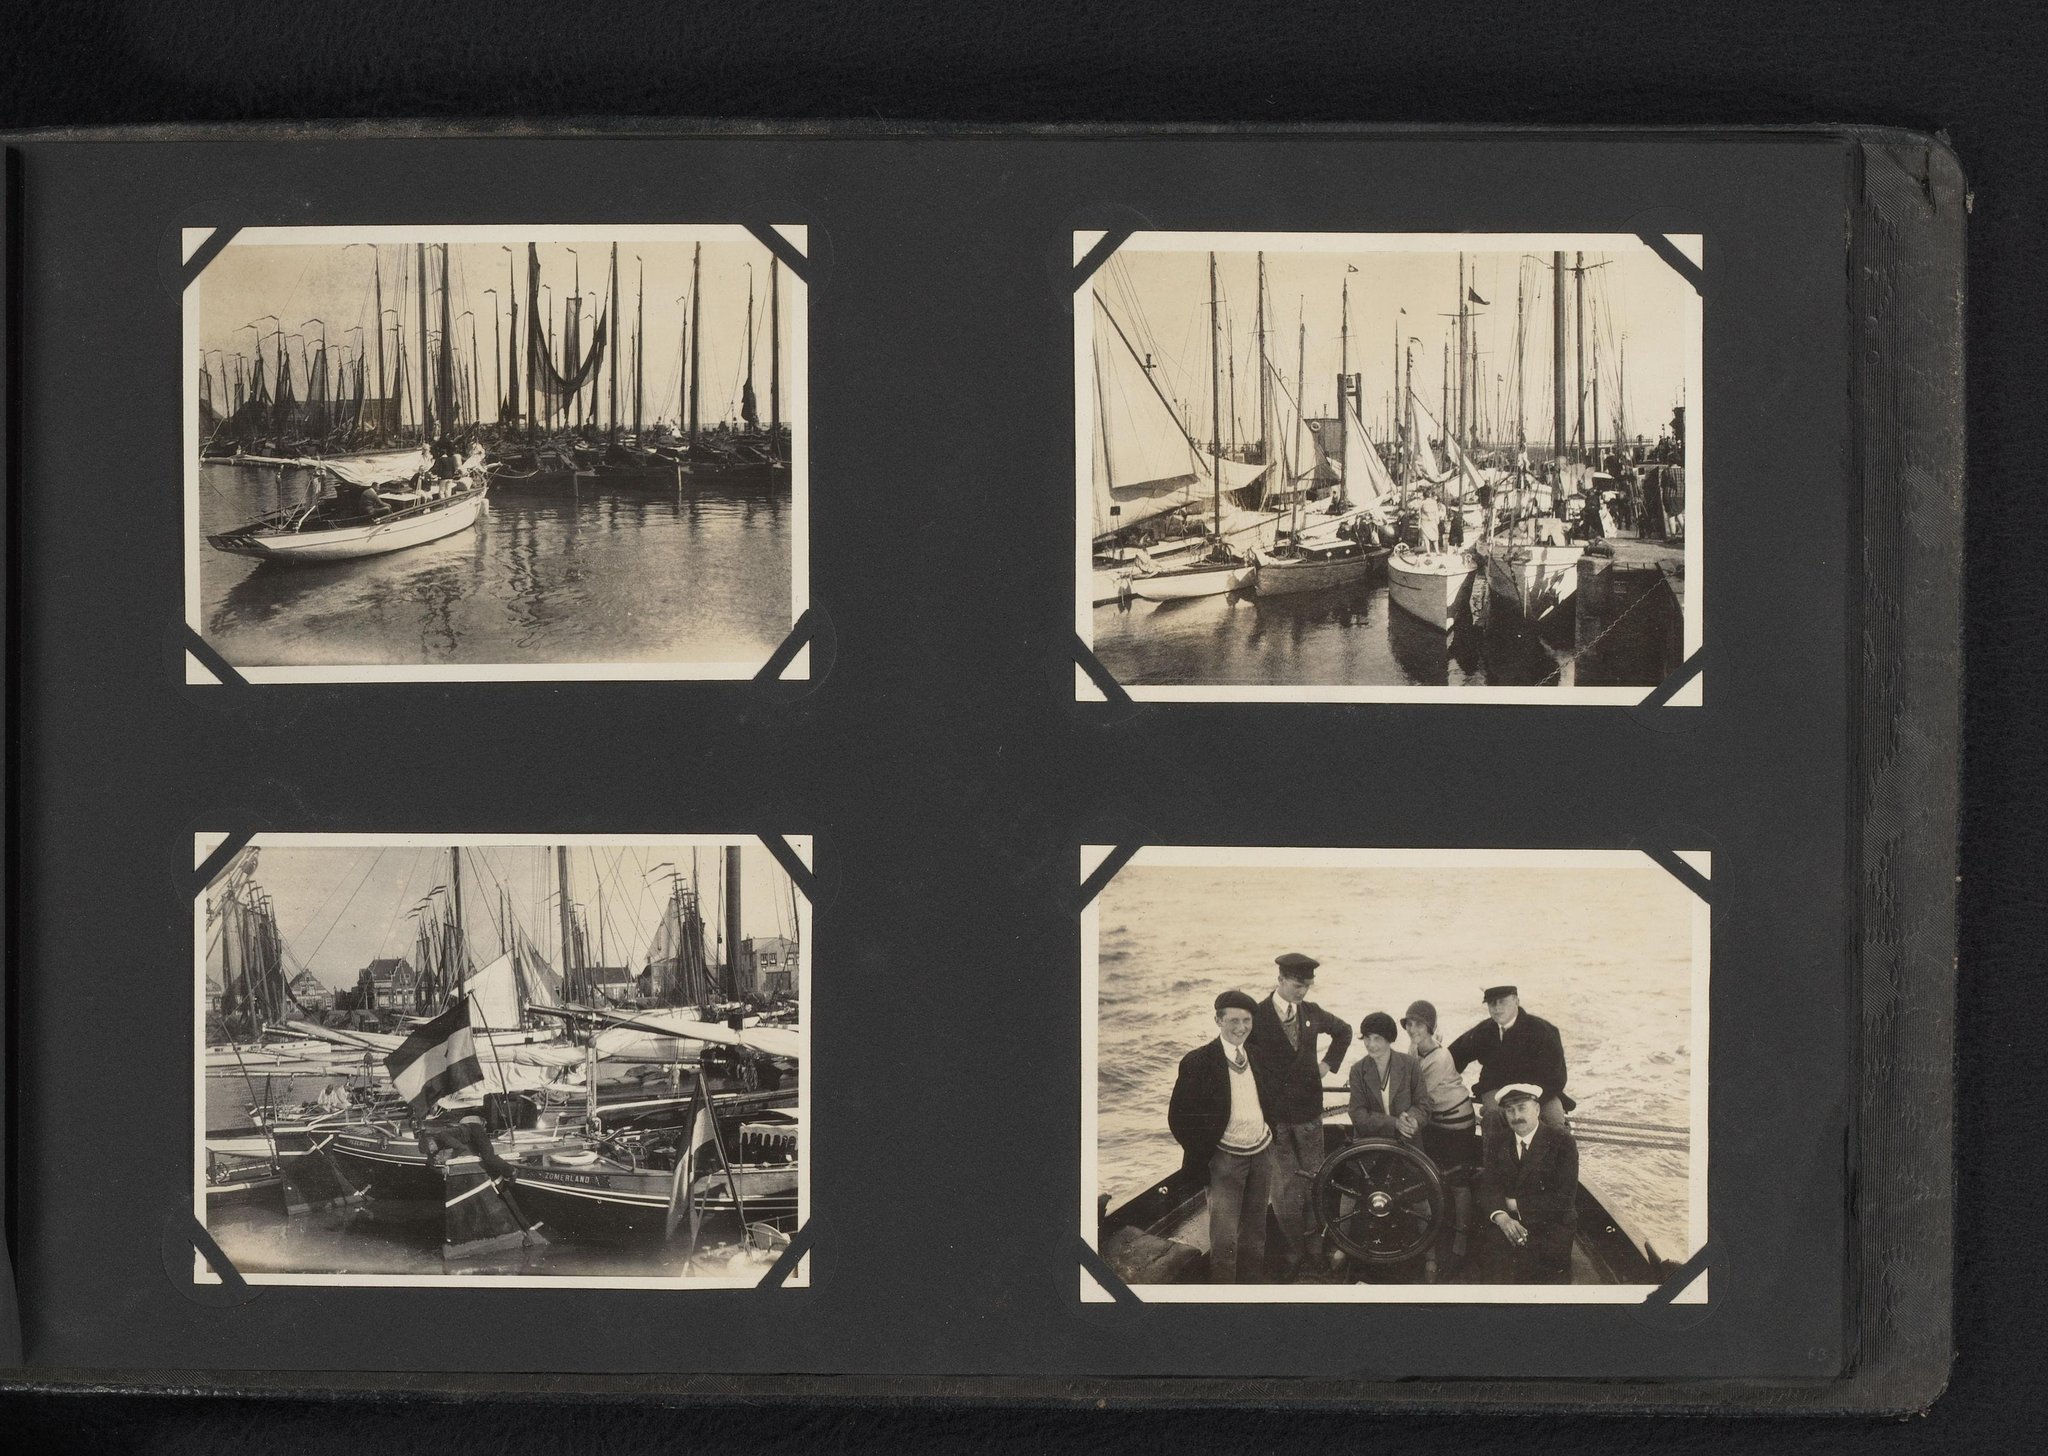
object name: album leaf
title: Vier foto's van een haven en een gezelschap op een boot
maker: hendrik herman van den berg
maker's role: amateurfotograaf, jurist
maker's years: 1875-1944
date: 1928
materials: paper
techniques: gelatin silver print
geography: netherlands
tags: sailing-ship, sailing-boat, crew and passengers ~ ship, netherlands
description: Deze foto's maken deel uit van een album.